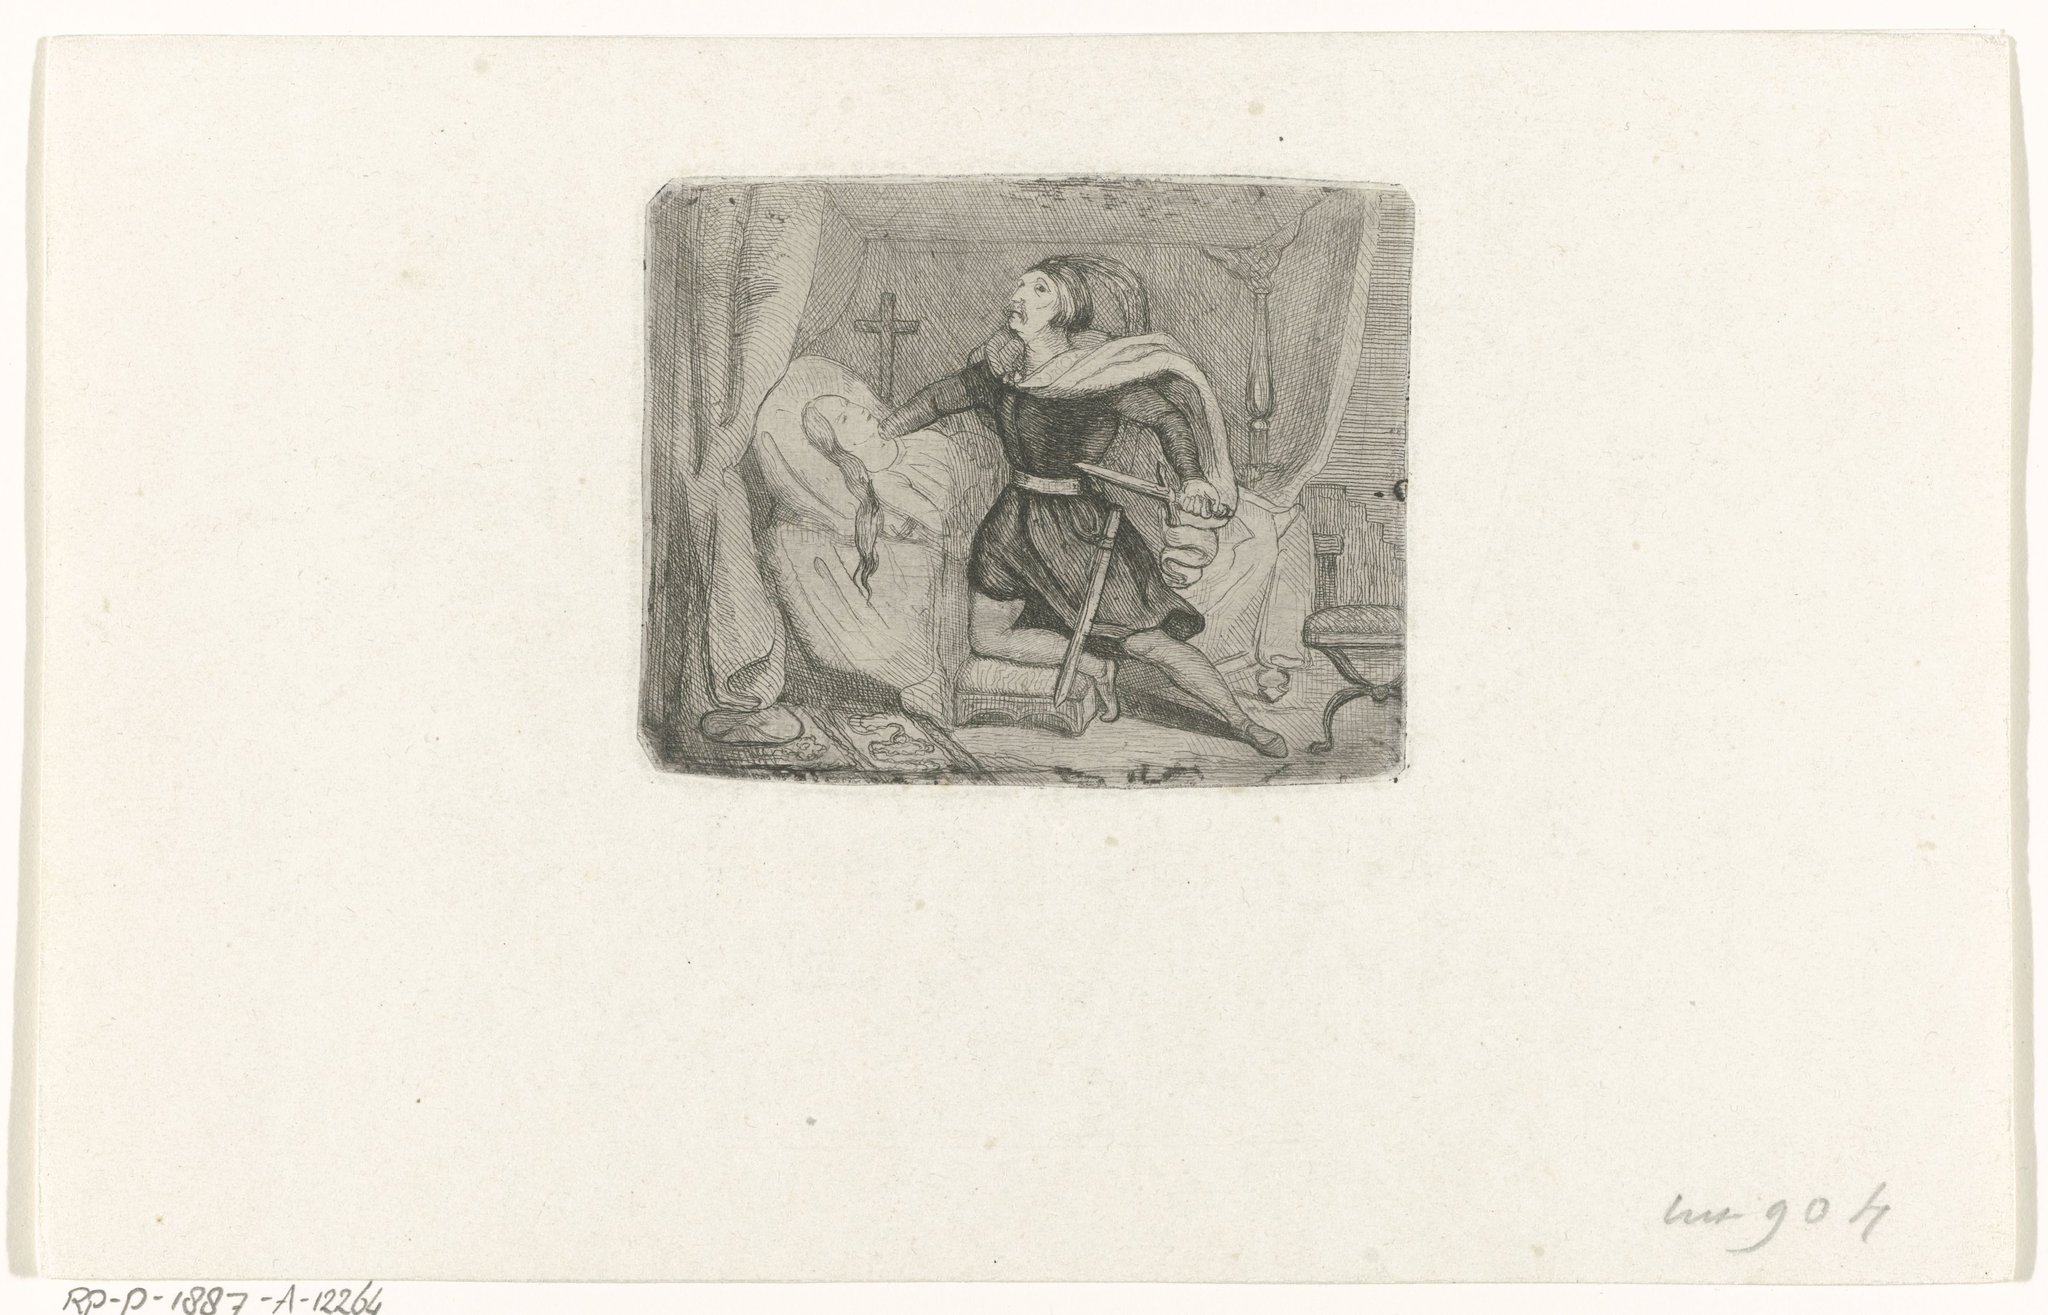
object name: print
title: Romeo en Julia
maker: arnoud schaepkens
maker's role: print maker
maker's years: 1816-1904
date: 1831-1887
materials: paper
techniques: etching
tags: romeo, juliet, seeking death, suicide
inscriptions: collector's mark: Lugt 2228